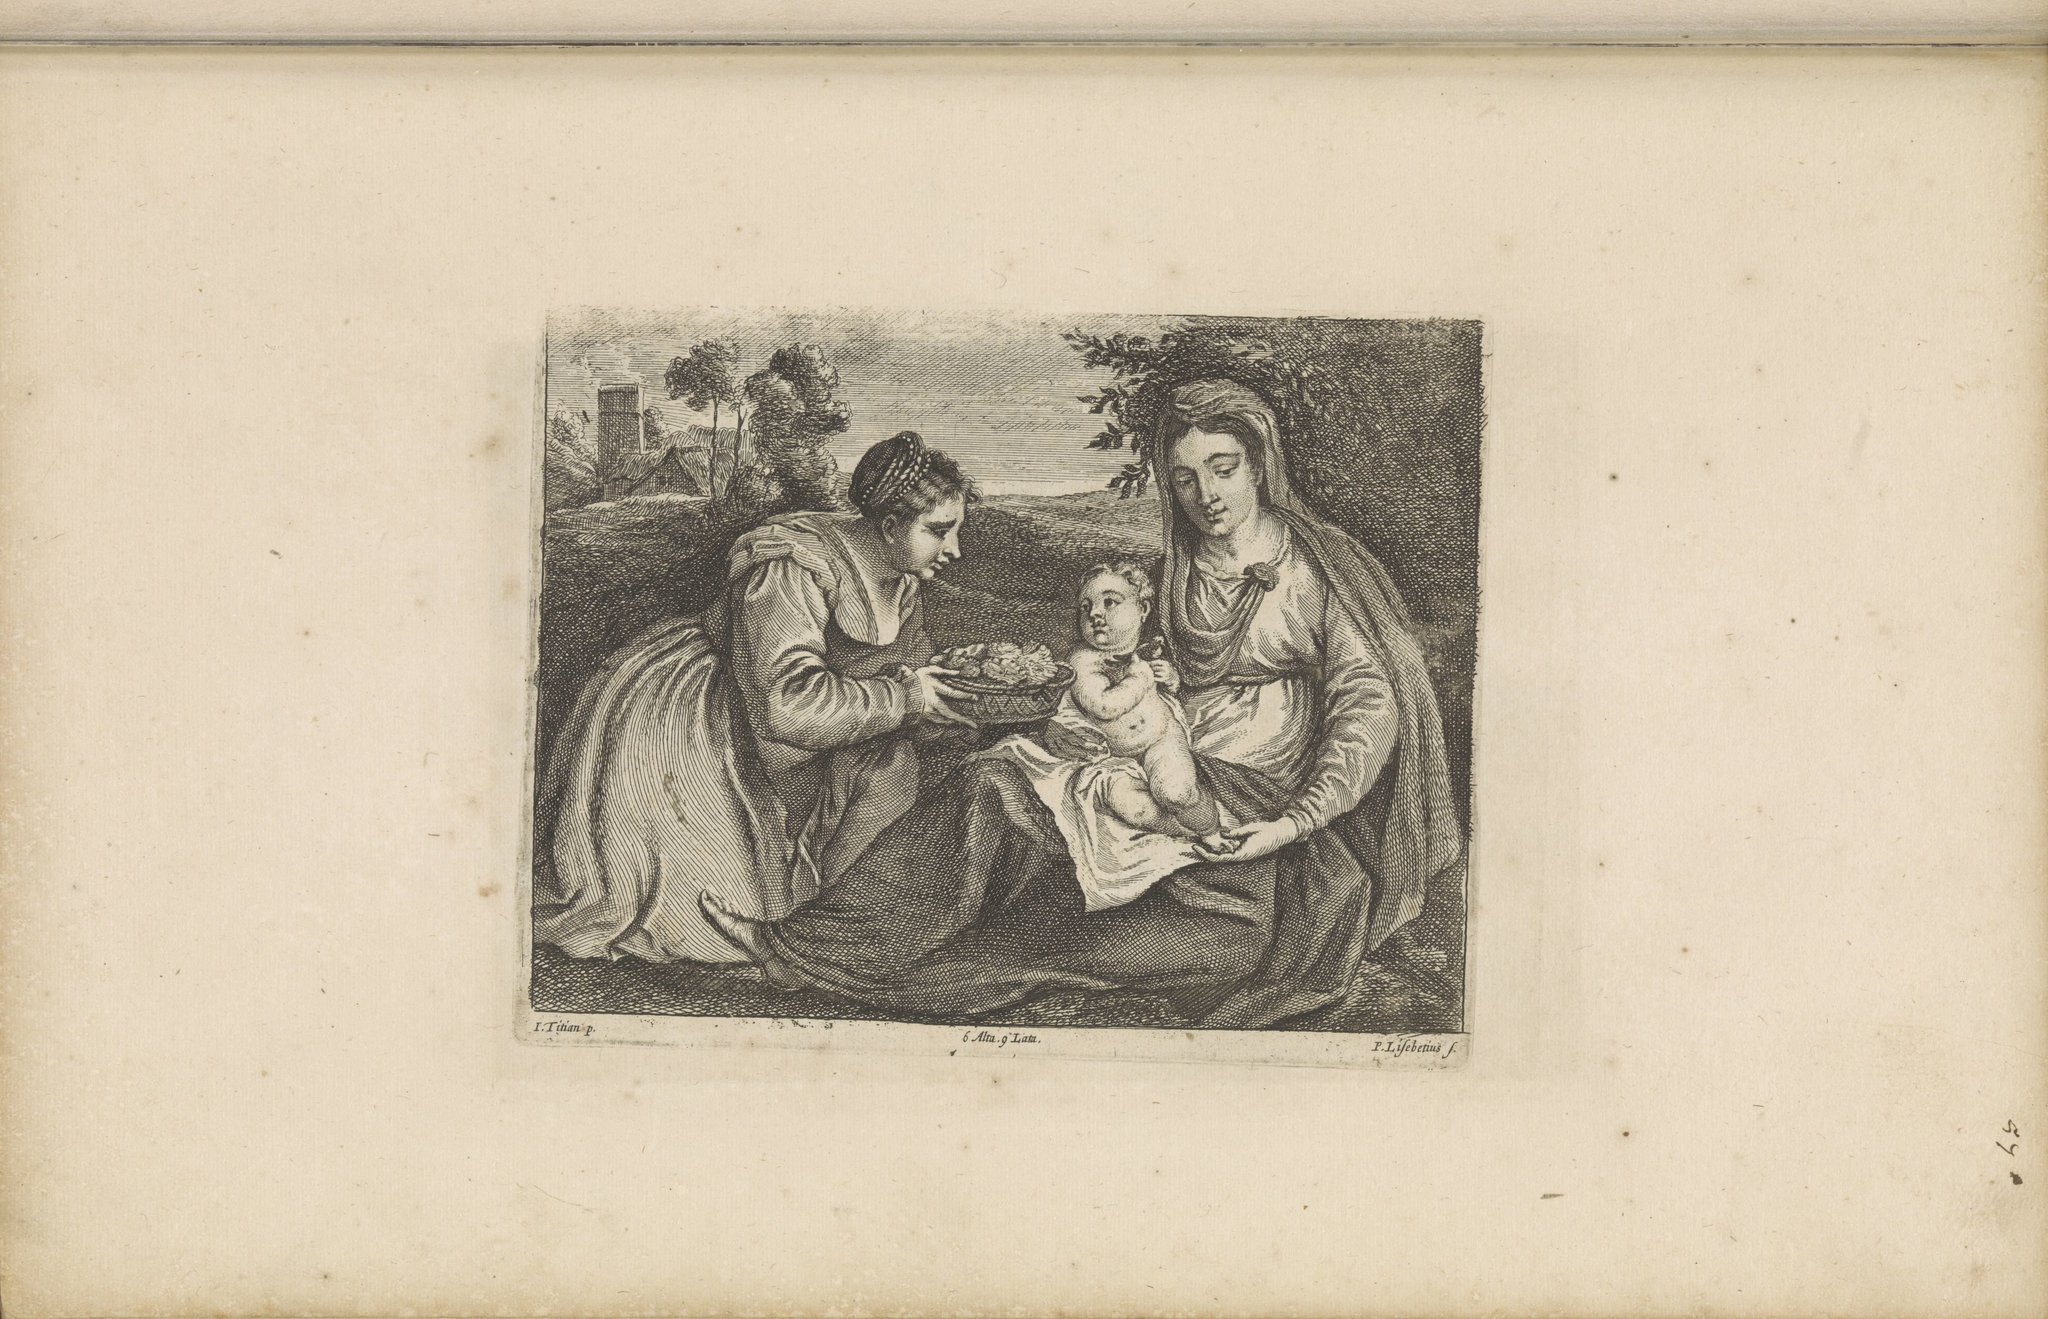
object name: print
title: H. Dorothea biedt het Christuskind een bloemenmand aan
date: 1660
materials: paper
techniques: etching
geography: brussels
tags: the virgin martyr dorothea of caesarea; possible attributes: basket of roses and apples, child with basket of roses, garland of roses, roses in hand or lap (+ mary), landscapes in the temperate zone, madonna: mary sitting on the ground, the christ-child in her lap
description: David Teniers heeft waarschijnlijk van alle schilderijen uit de collectie van Leopold Willem van Oostenrijk een olieverfstudie op doek of paneel vervaardigd (zgn. pasticcio), die als voorbeeld voor de prentmakers diende. Het is niet altijd duidelijk of de pasticci door hem zijn gemaakt of door zijn atelier. Niet alle pasticci zijn overgeleverd.